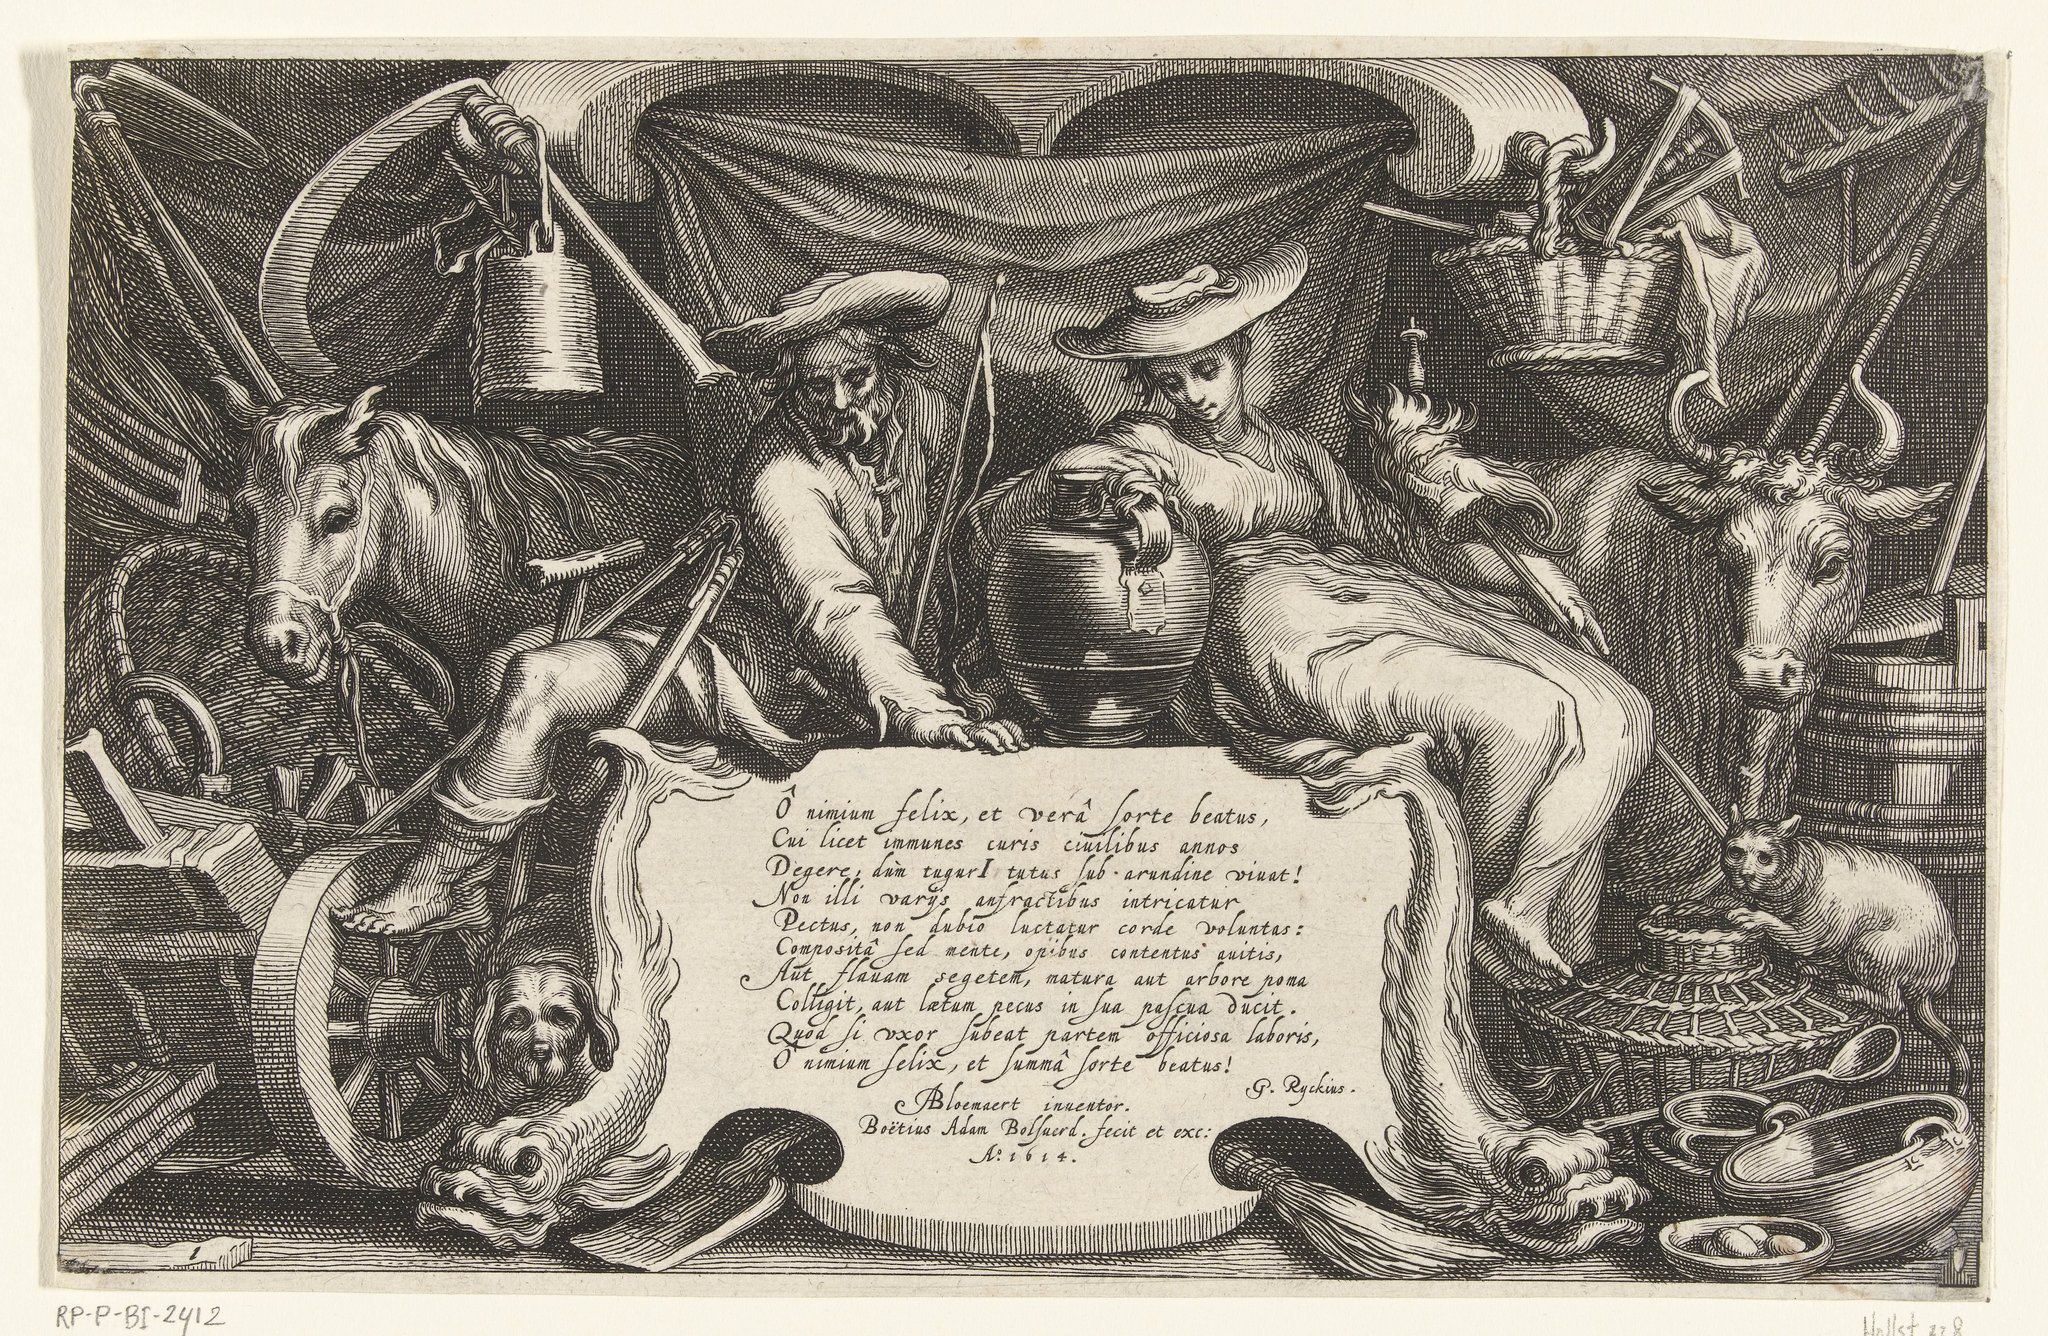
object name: titelprent, frontispice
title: Boer en boerin tussen landbouwwerktuigen en paard en koe als omlijsting van cartouche met vers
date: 1614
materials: paper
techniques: engraving, etching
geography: amsterdam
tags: cow, farmers, agricultural implements, horse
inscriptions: inscription: ‘O nimium felix ... summâ sorte beatus!’, collector's mark: Lugt 240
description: Titelprent voor serie van twintig Landschappen met boerderijen naar ontwerp van Abraham Bloemaert.